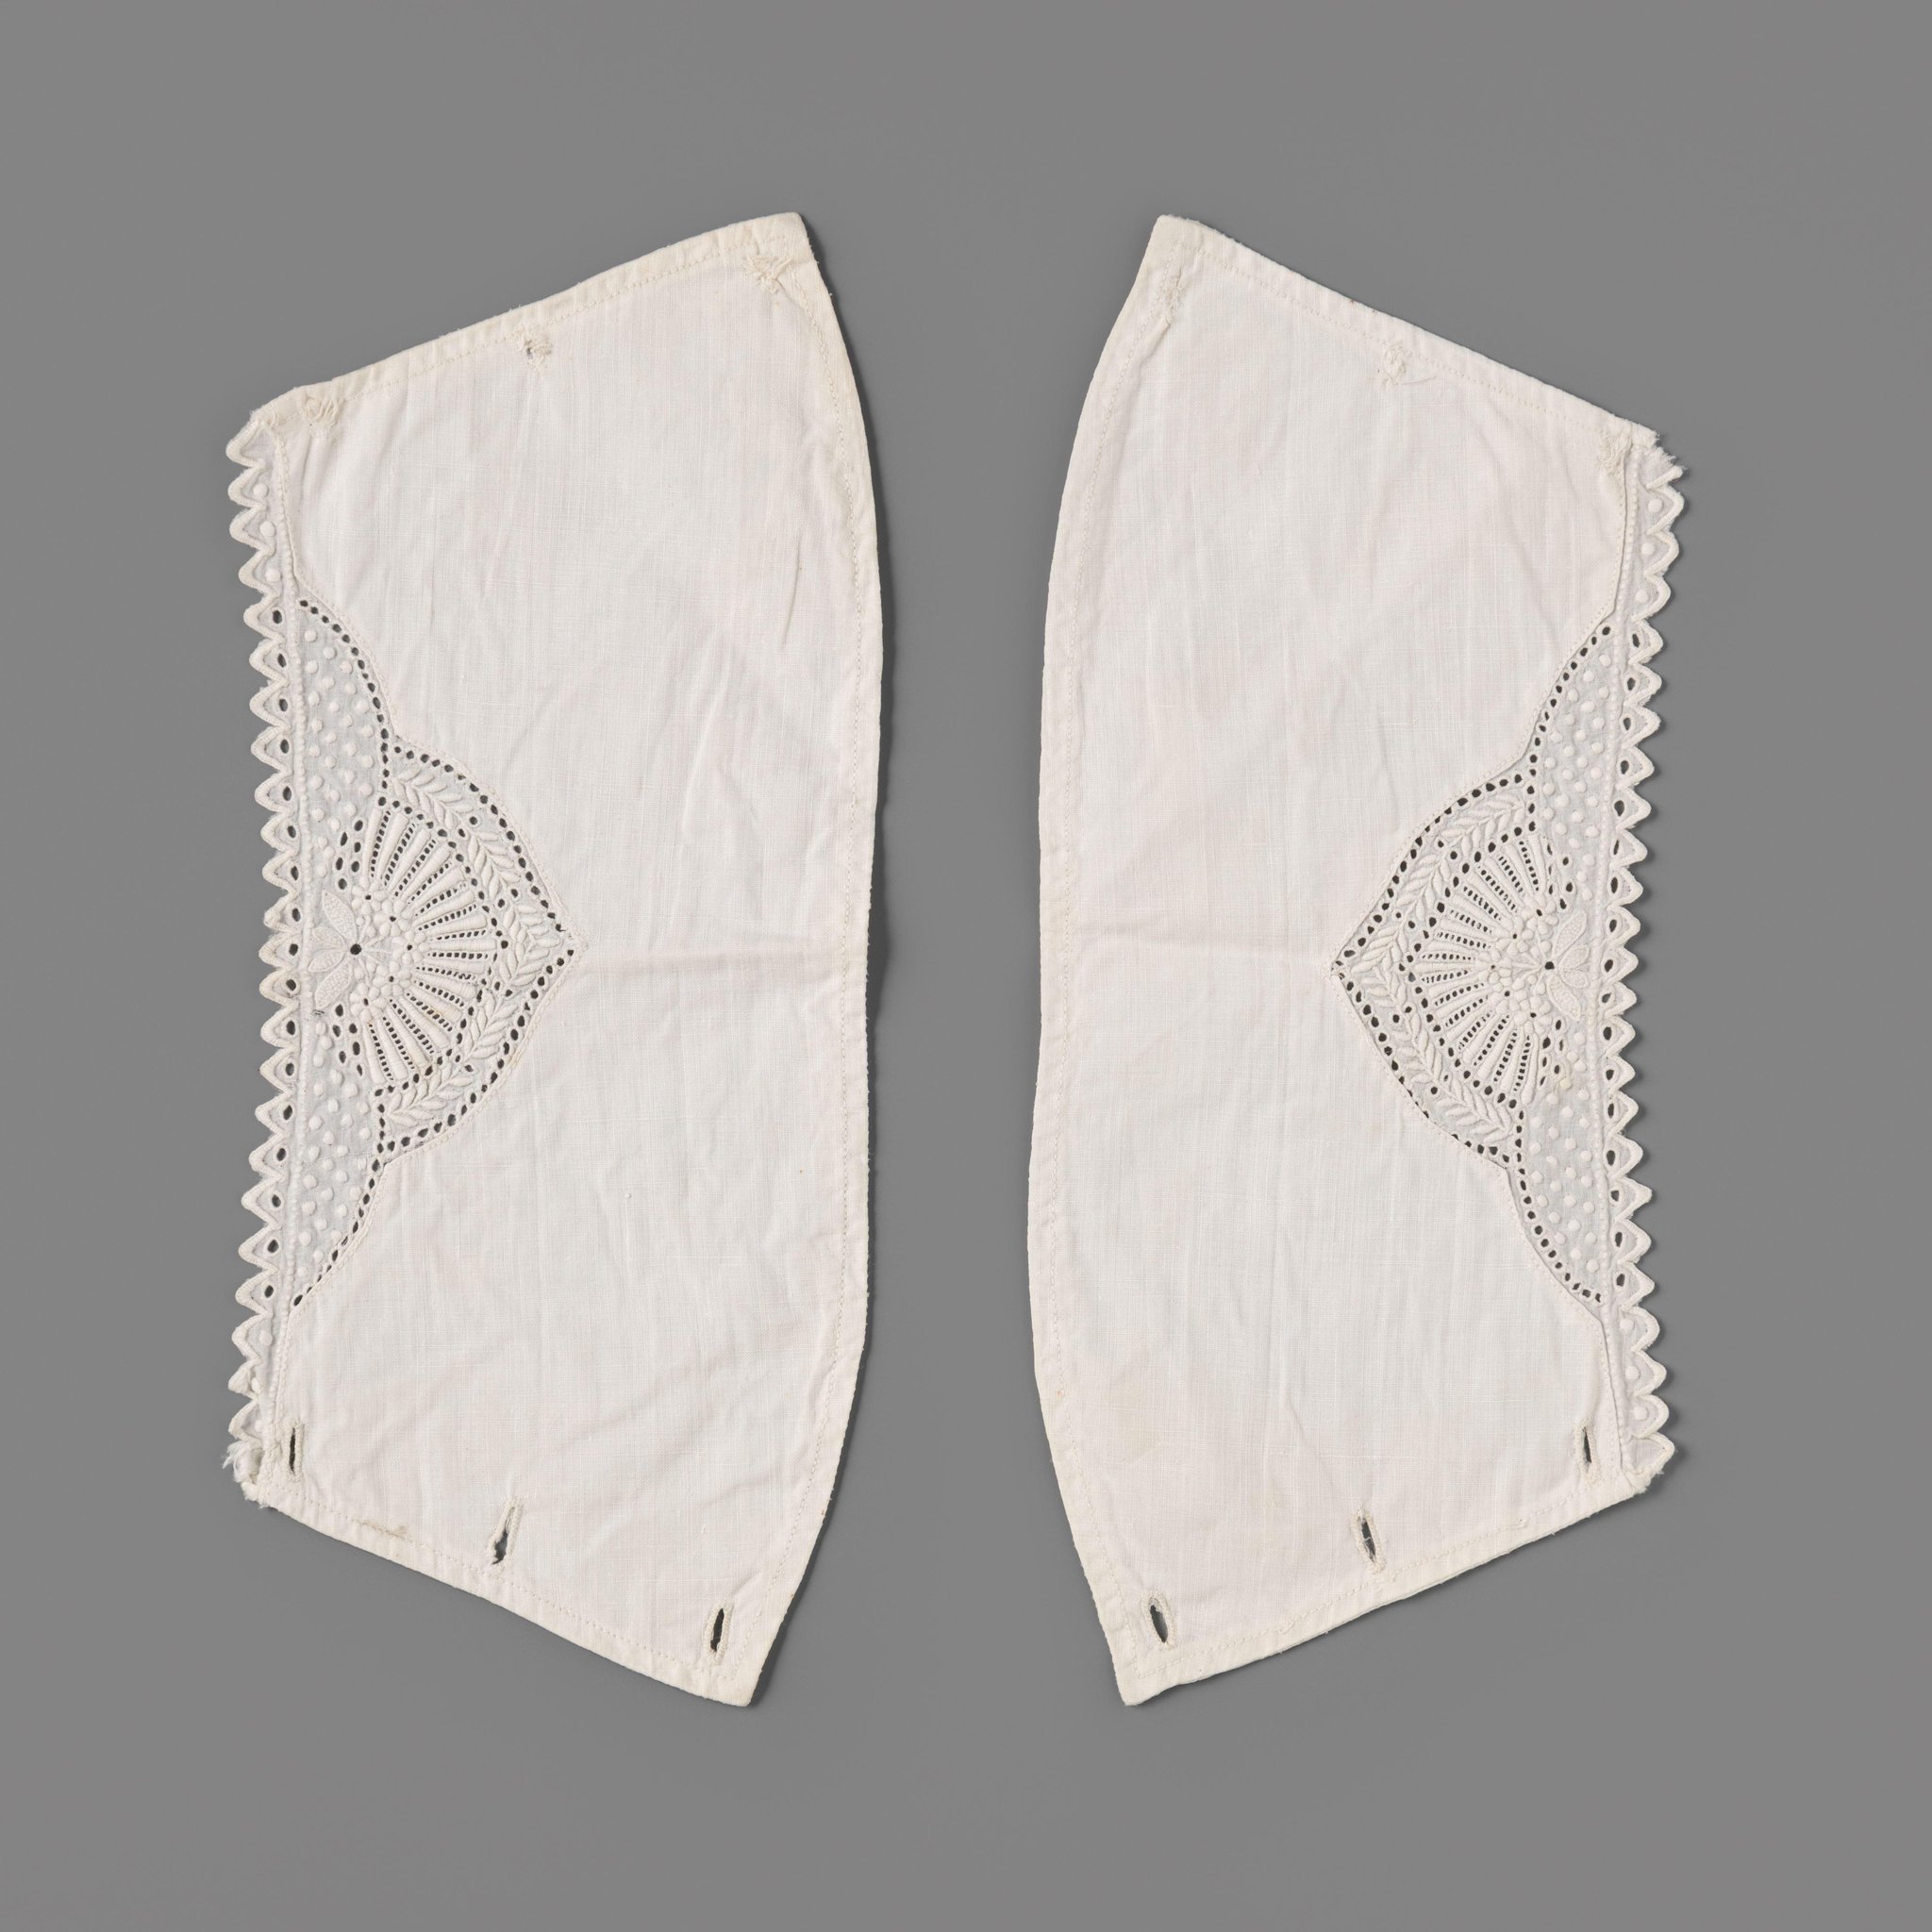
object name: cuff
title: Manchet van batist versierd met witwerk in de vorm van moesjes, veren en bloemen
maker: Anonymous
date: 1870-1880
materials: textile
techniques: embroidery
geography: netherlands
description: Manchet van batist, versierd met witwerk in de vorm van moesjes, veren en bloemen. De manchet is gevoerd en heeft drie knoopsgaten. Deel van een paar.